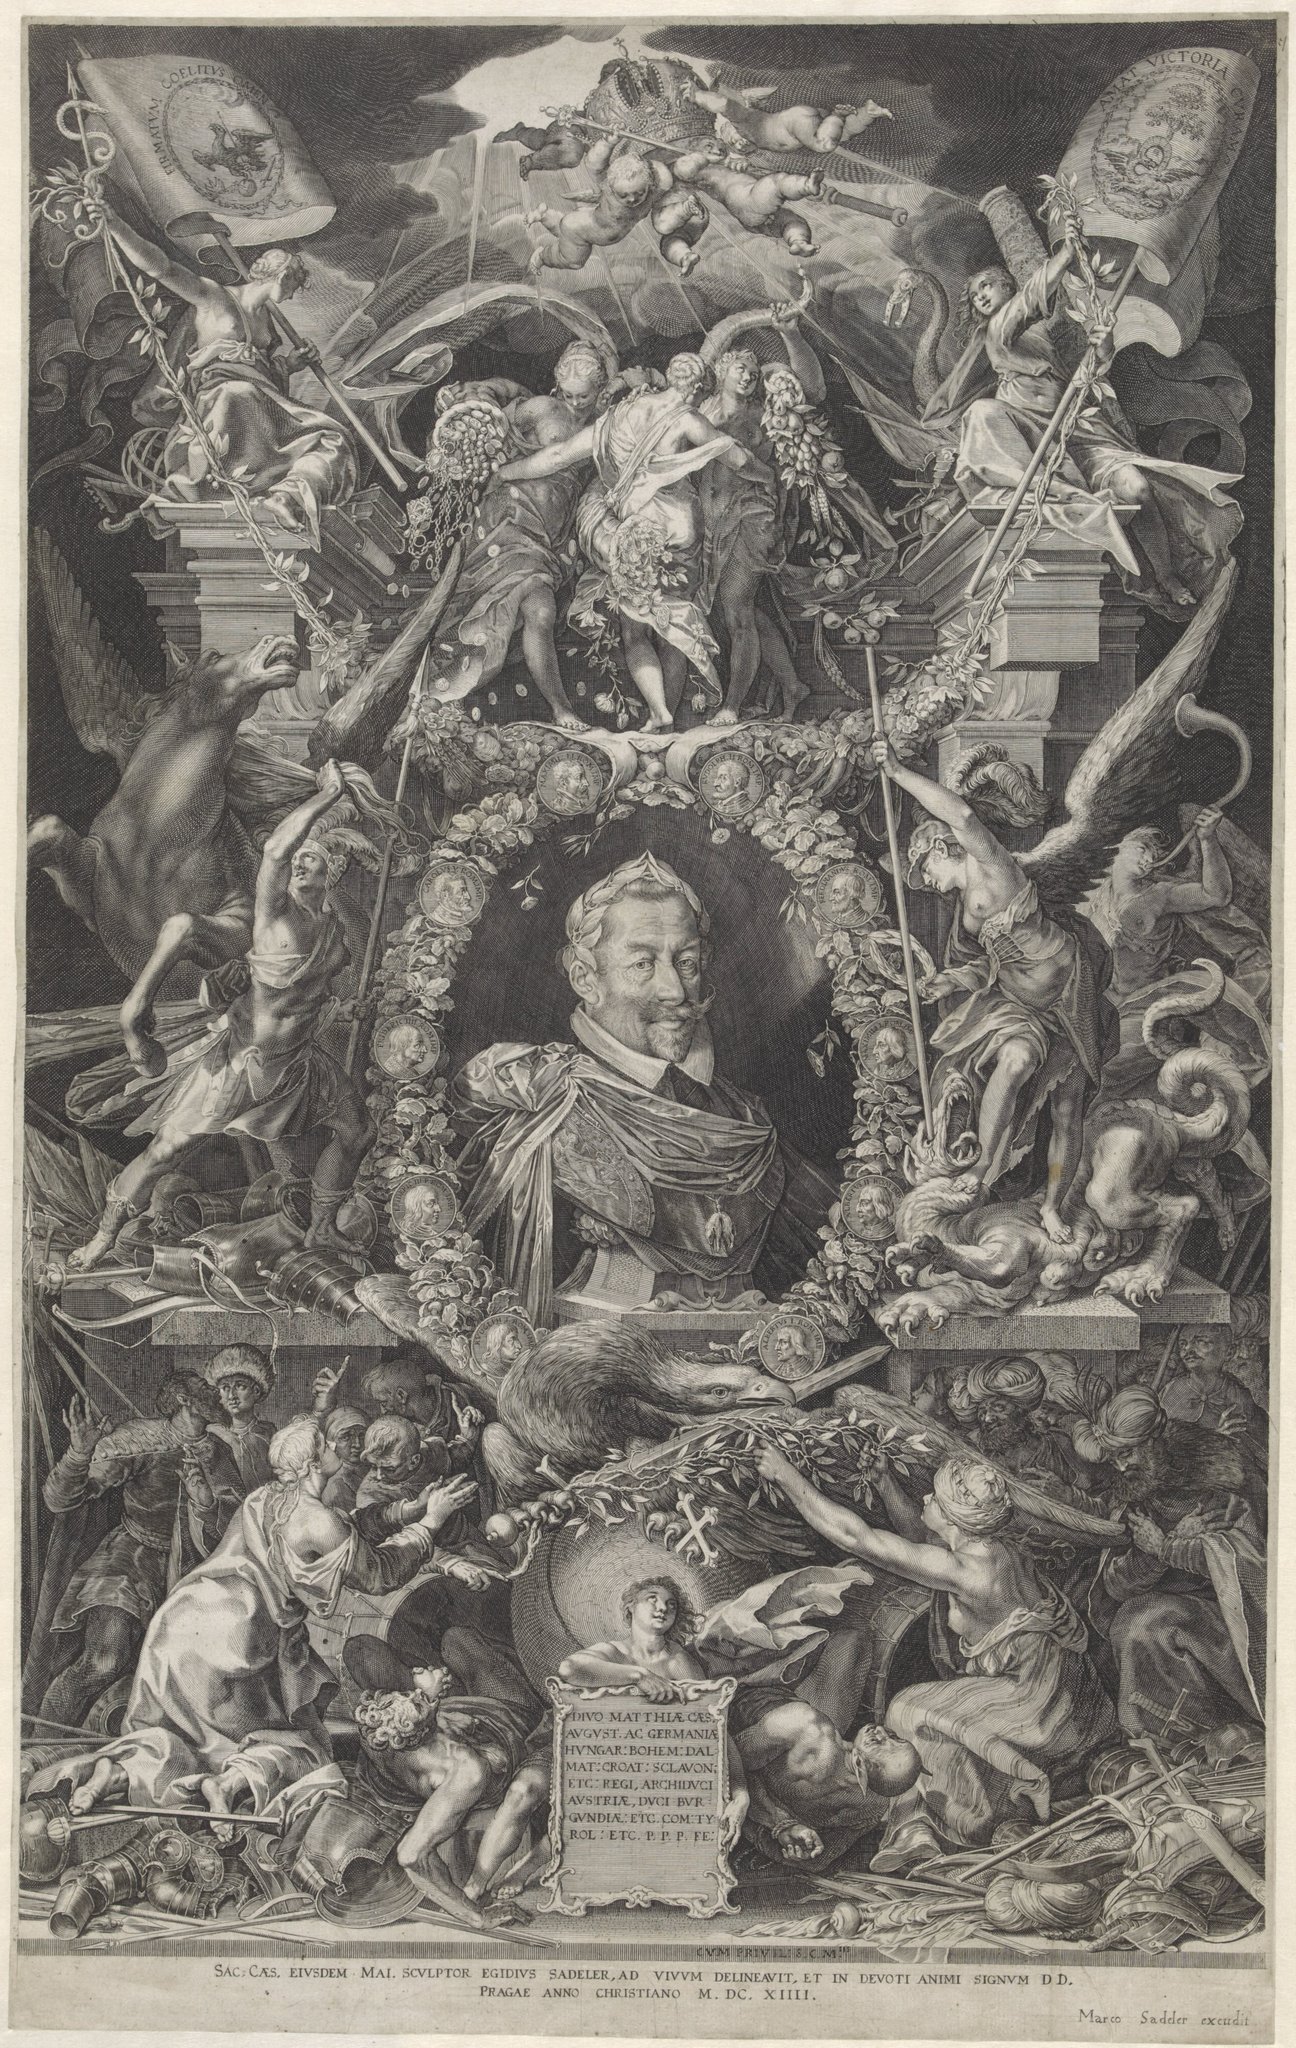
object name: print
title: Portret van keizer Matthias in allegorische omlijsting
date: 1614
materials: paper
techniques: engraving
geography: prague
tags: matthias van oostenrijk (rooms-duits keizer), pegasus, the winged horse, historical persons, fama as roman personification, dragon, allegory, personification of good government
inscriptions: collector's mark: Lugt 2228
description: Buste naar rechts van keizer Matthias met een lauwerkrans in een ovale omlijsting uit eikentakken. Op de takken tien medaillons met portretten van voorgangers. Onder de rijksadelaar knielen links zijn onderdanen en rechts de Turken. Midden onder een vrouw met een stenen tafel waarop de naam en titel van de geportretteerde. Links Afgunst en rechts een vastgebonden man met ezelsoren. Als symbolen voor de gematigdheid van de keizer en de overwinning wordt links Pegasus getemd en rechts een draak gedood. Faam verkondigt met haar bazuin de triomf van de keizer. Bovenaan laten de drie Gratiën uit hun hoornen des overvloeds vruchten en rijkdommen, het goede der aarde, op hem neerkomen. Daarboven vier putti met een kroon en een scepter. Onder de voorstelling een tweeregelige, Latijnse tekst met een uitgebreide signatuur.